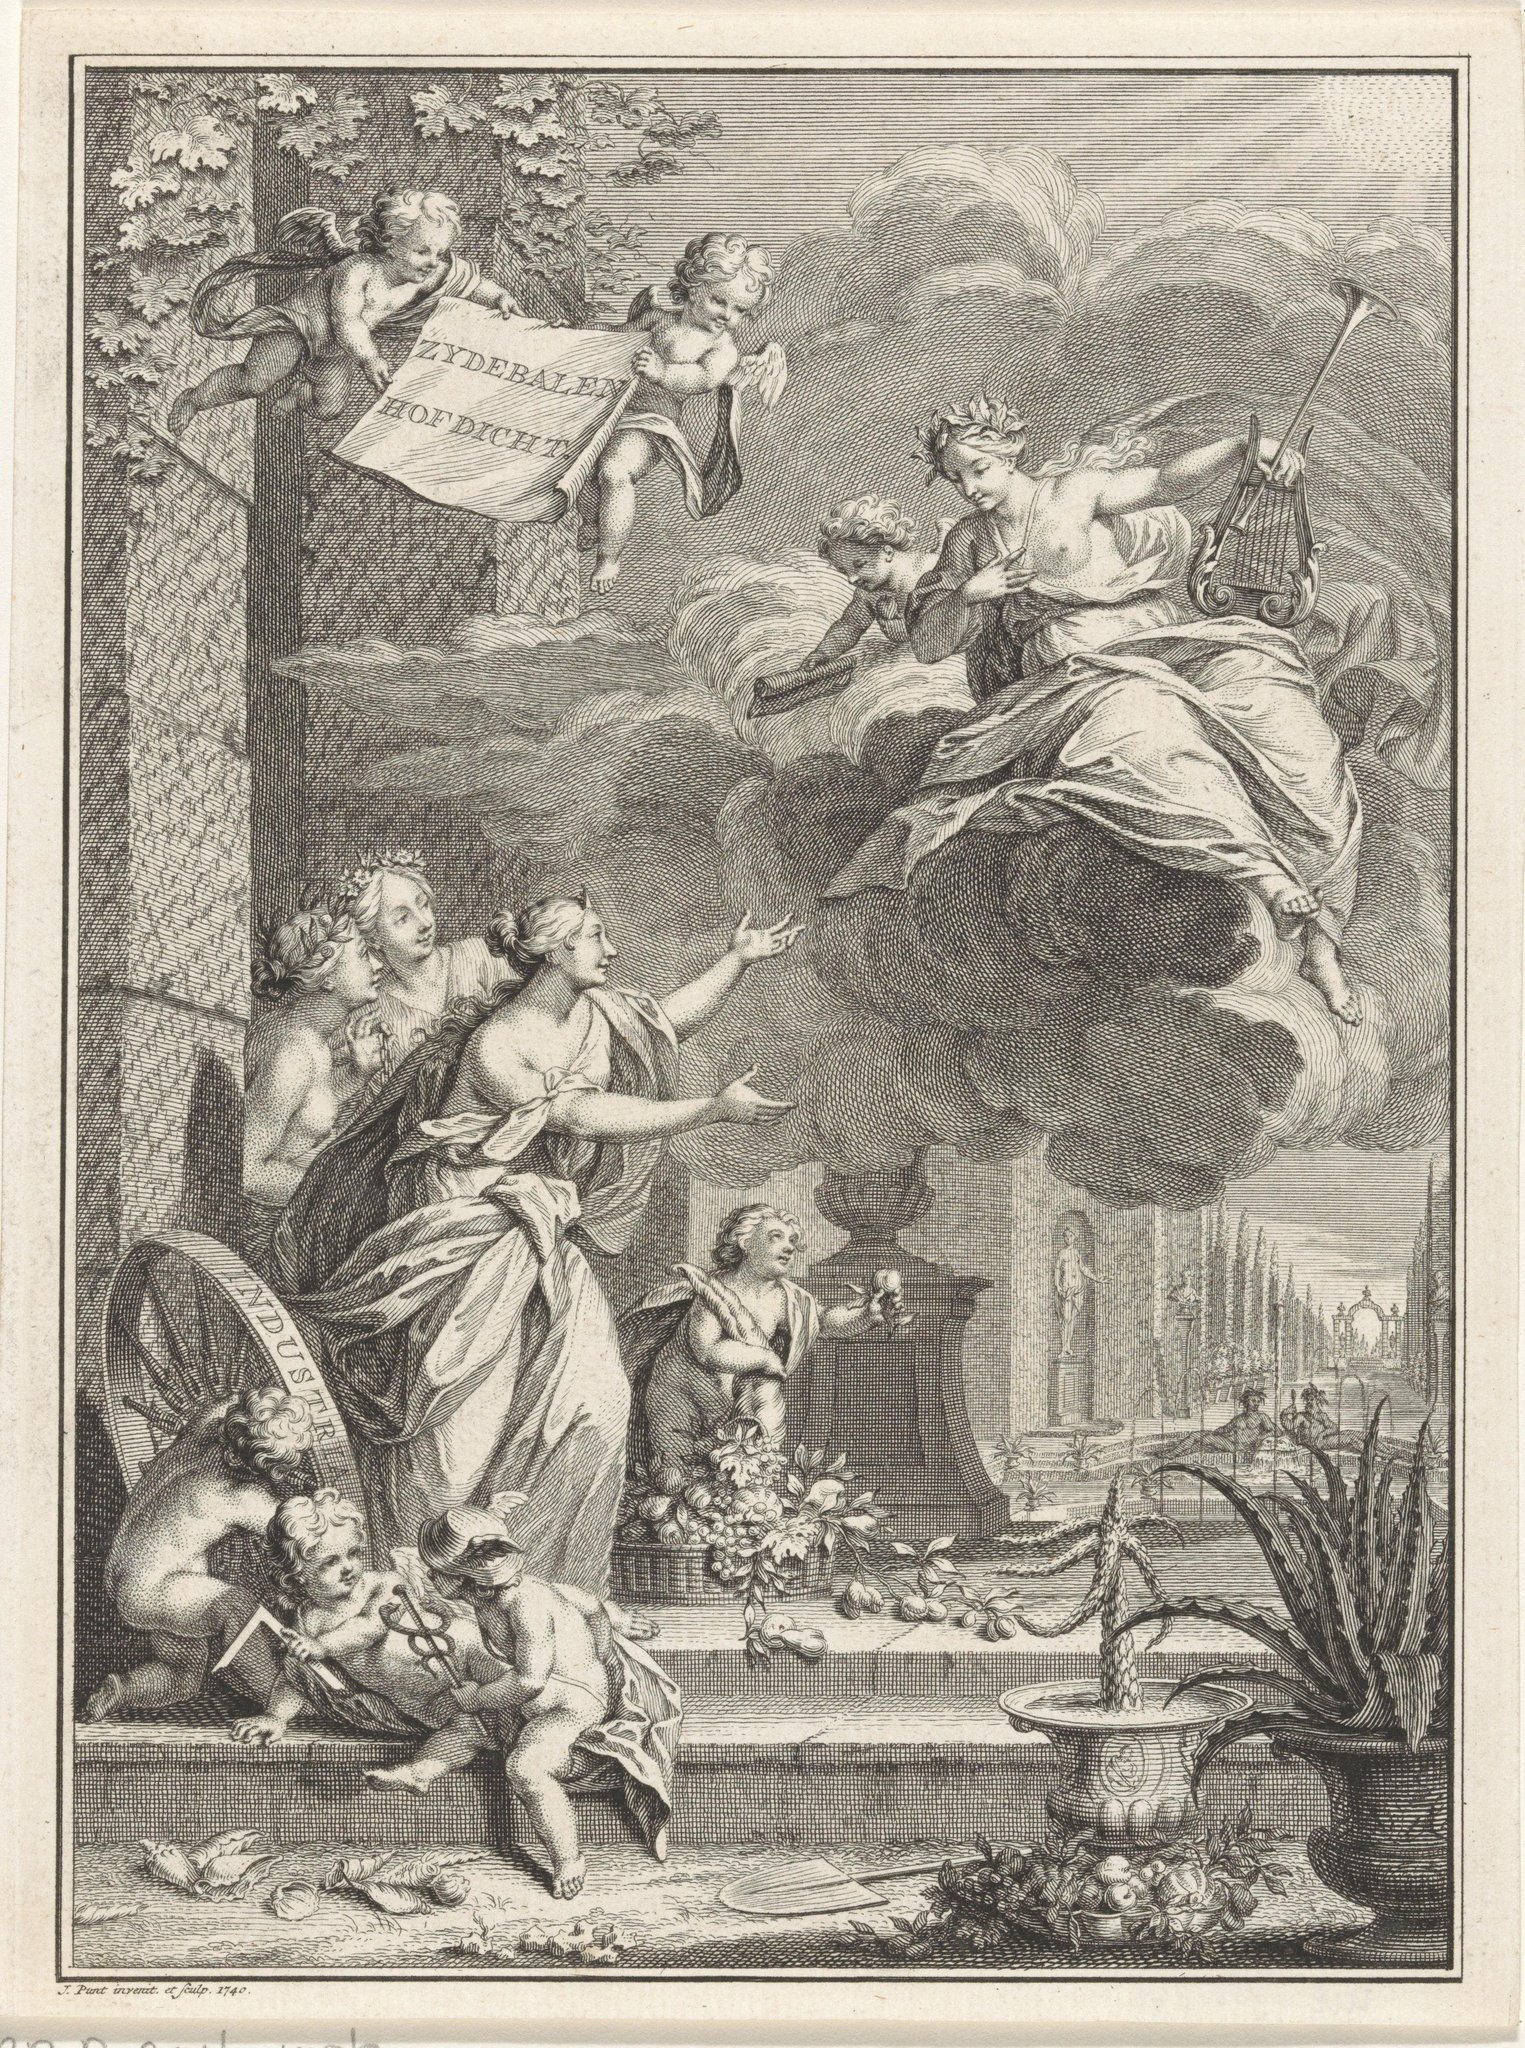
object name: titelblad, titelpagina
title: Poëzie in gesprek met allegorische figuren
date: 1740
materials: paper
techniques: engraving, etching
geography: delft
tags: hospitality; 'hospitalità' (ripa), humanity, politeness; 'cortesia', 'humanità' (ripa), friendship; 'amicitia' (ripa), symbolic representations, allegories and emblems ~ poetry; 'poesia' (ripa)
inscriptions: collector's mark: Lugt 2228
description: Poëzie die vanaf een wolk neerdaalt in een tuin, in gesprek met de allegorische vrouwfiguren Gastvrijheid, Vriendschap en Beleefdheid. Op de voorgrond drie putti die de Koopzorg (met caduceus), Werktuigkunde (met winkelhaak) en Landvreugd (met rad) symboliseren. In de lucht vliegen twee putti met een doek waarop de titel in het Nederlands.